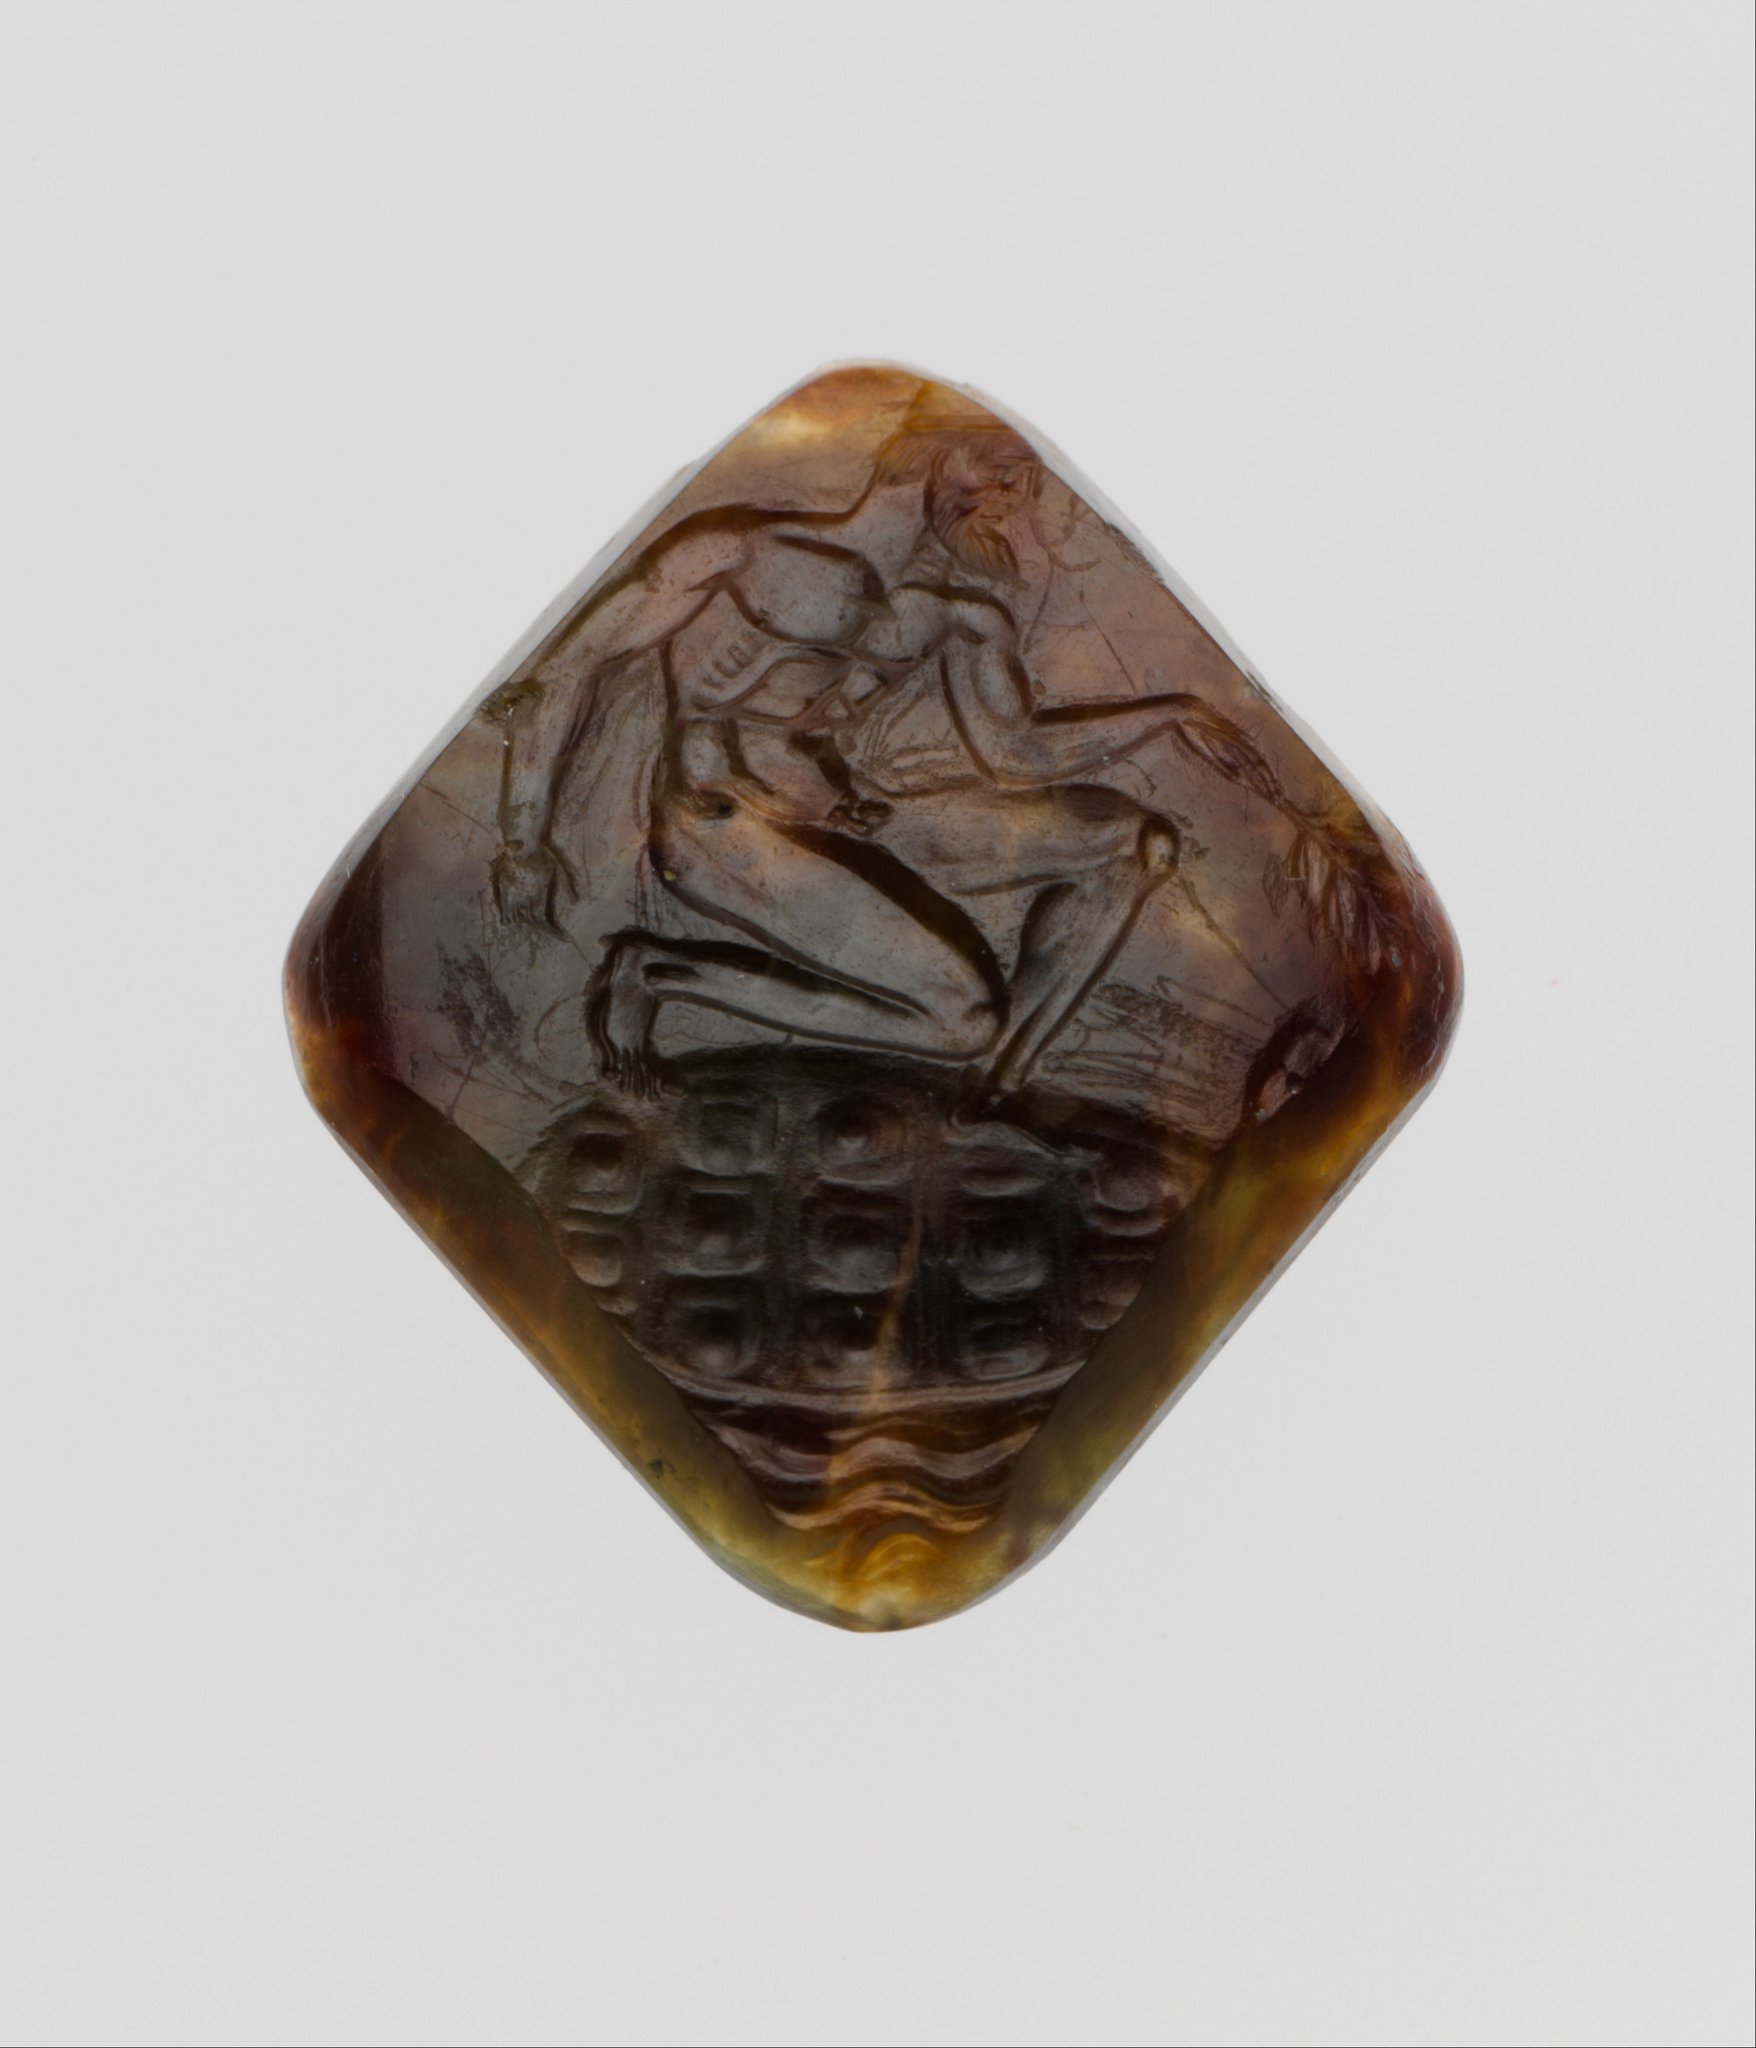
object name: intaglio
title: Moss agate ring stone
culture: roman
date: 1-100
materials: stone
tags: male nudes,turtles